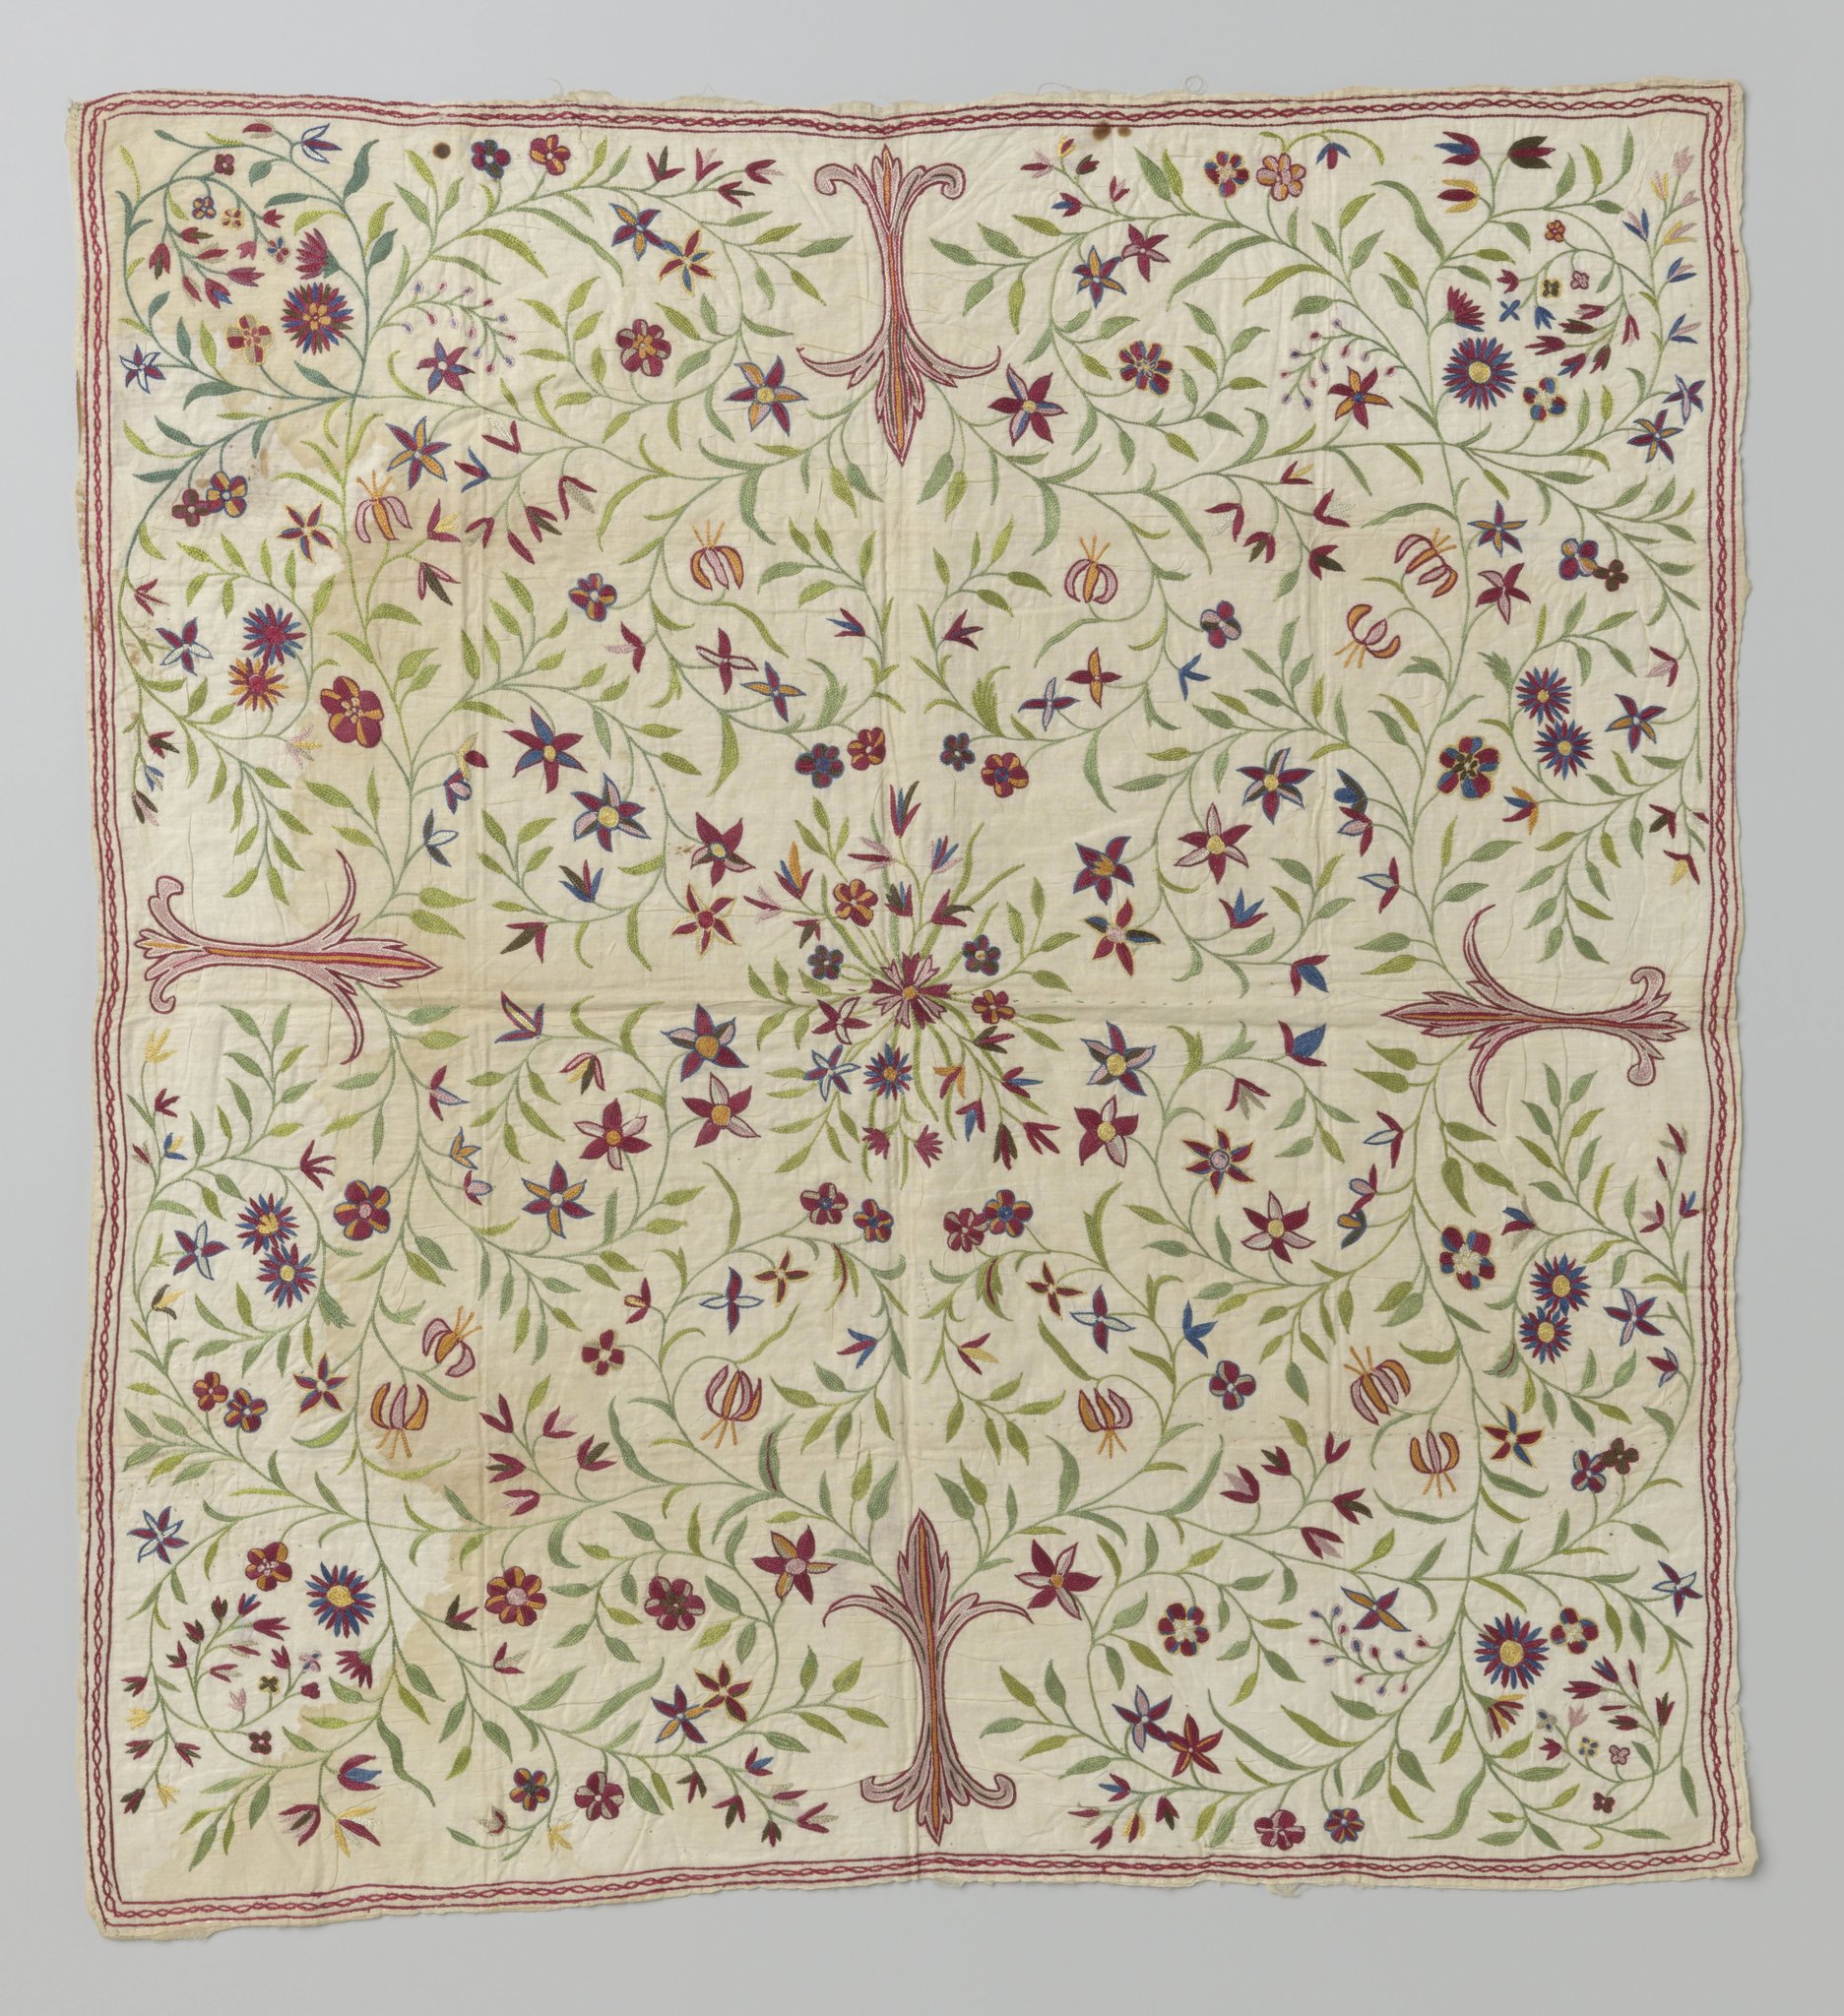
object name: textile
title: Kleed van oosterse textiel met veelkleurig borduurwerk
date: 1800-1899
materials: cotton, silk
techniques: tambouring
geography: east indies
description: Kleed van veelkleurig getamboereerde katoen, versierd met bloemranken en ornament, gevoerd met katoen.